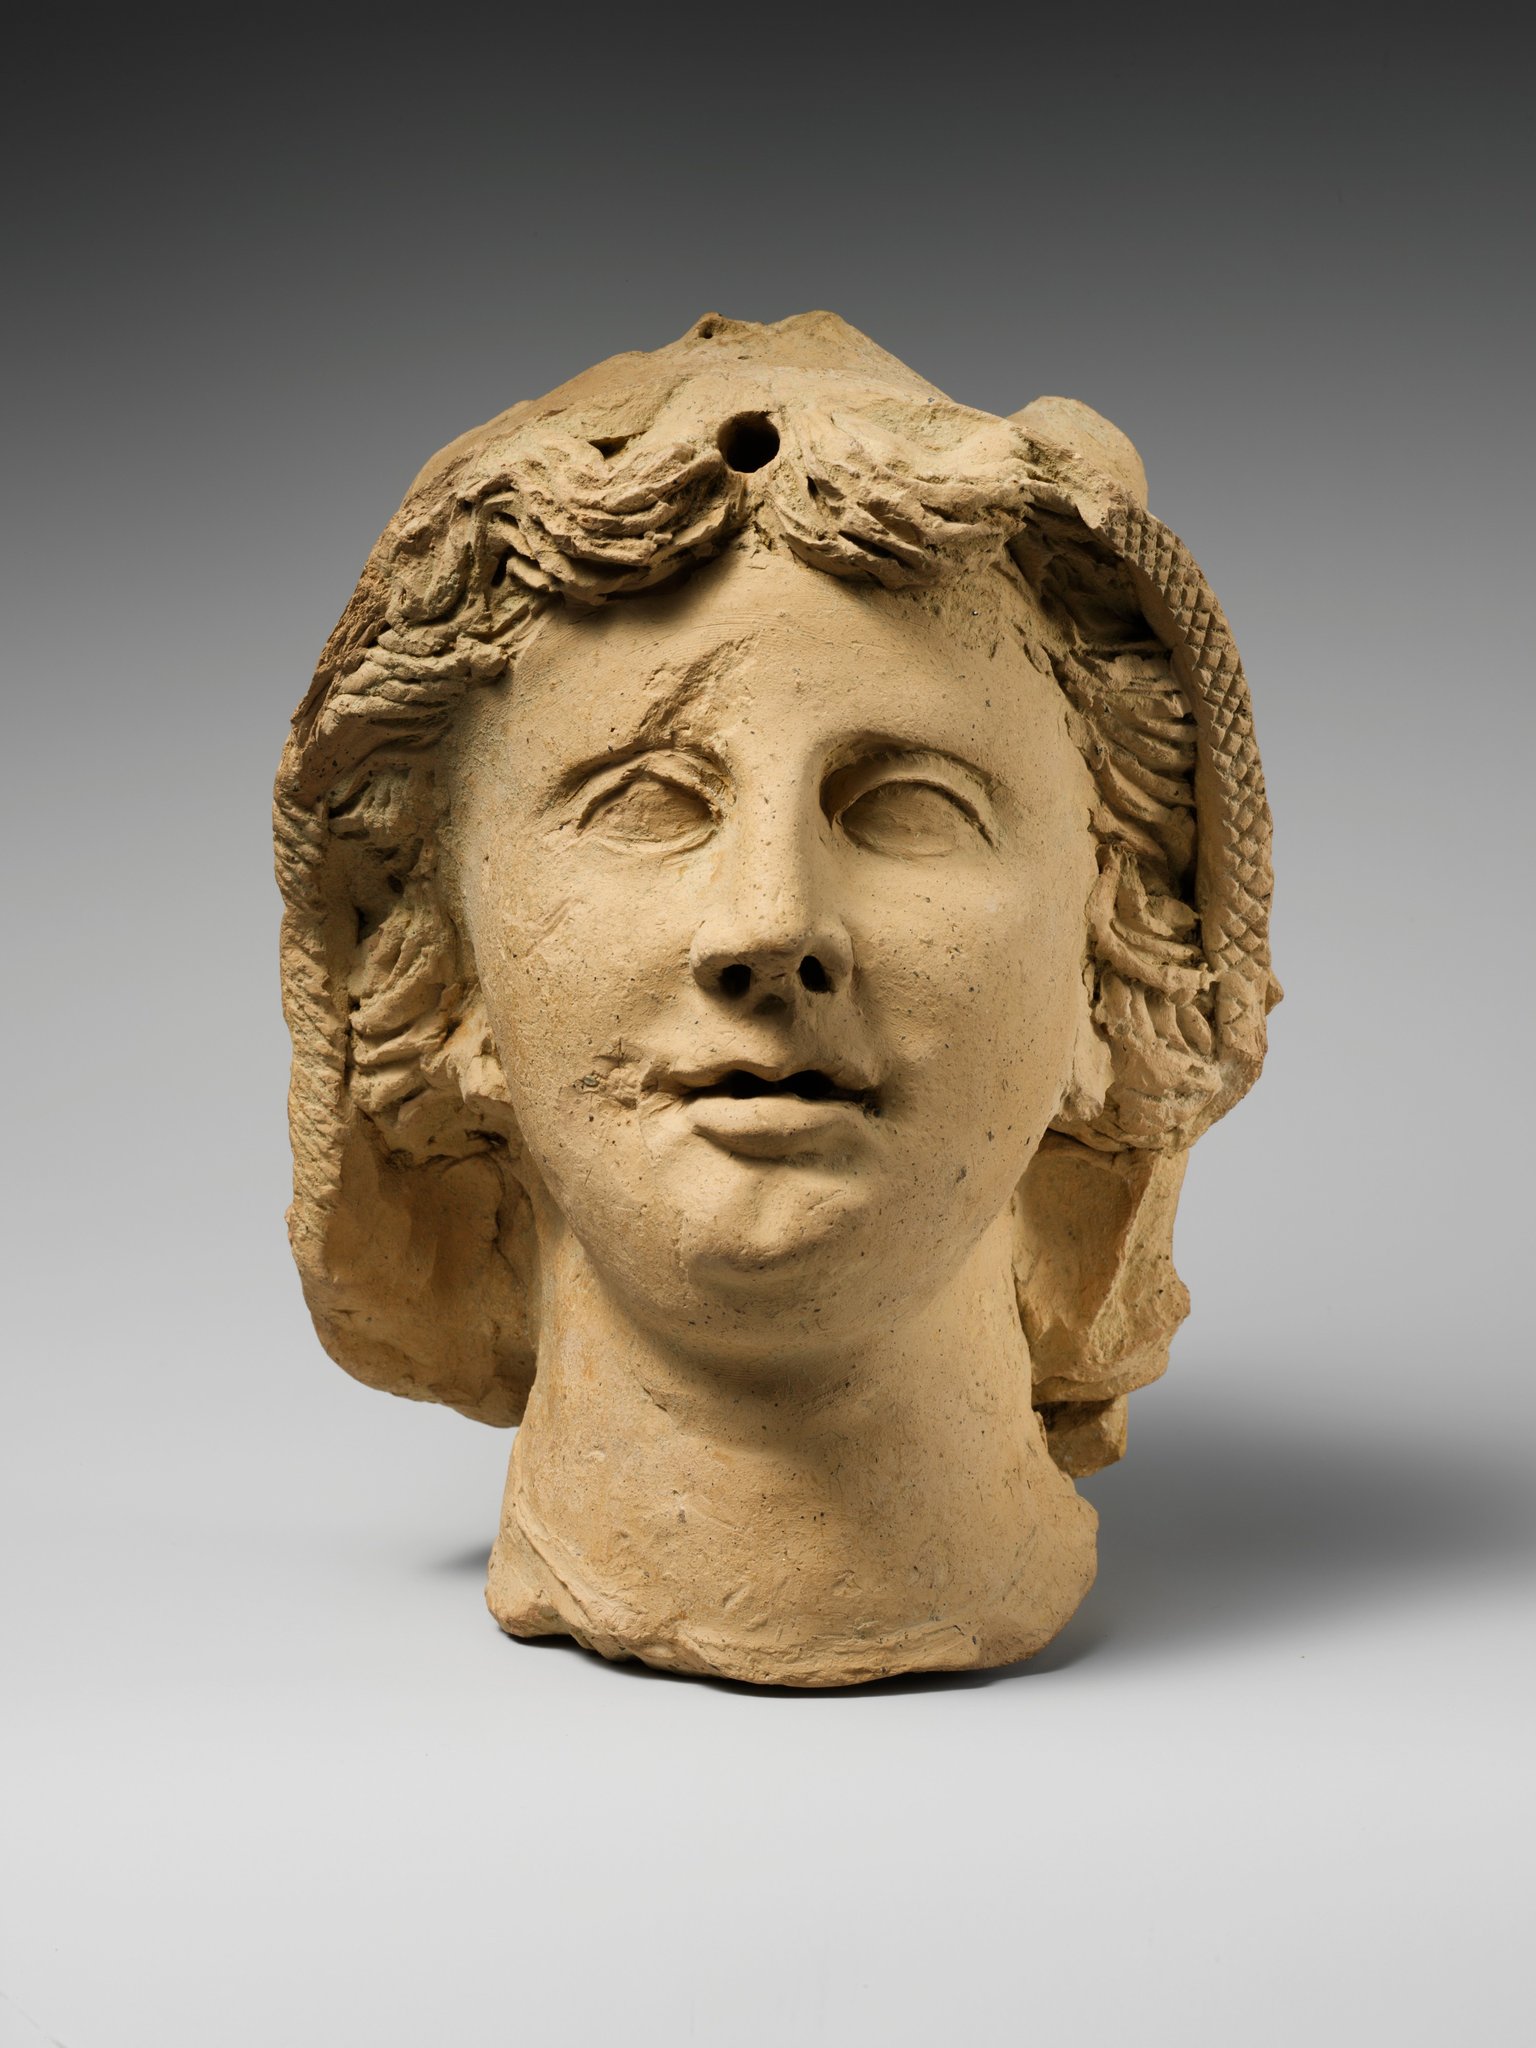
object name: head of a youth wearing a helmet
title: Terracotta head of a youth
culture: etruscan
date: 300-101 BCE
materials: terracotta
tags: heads